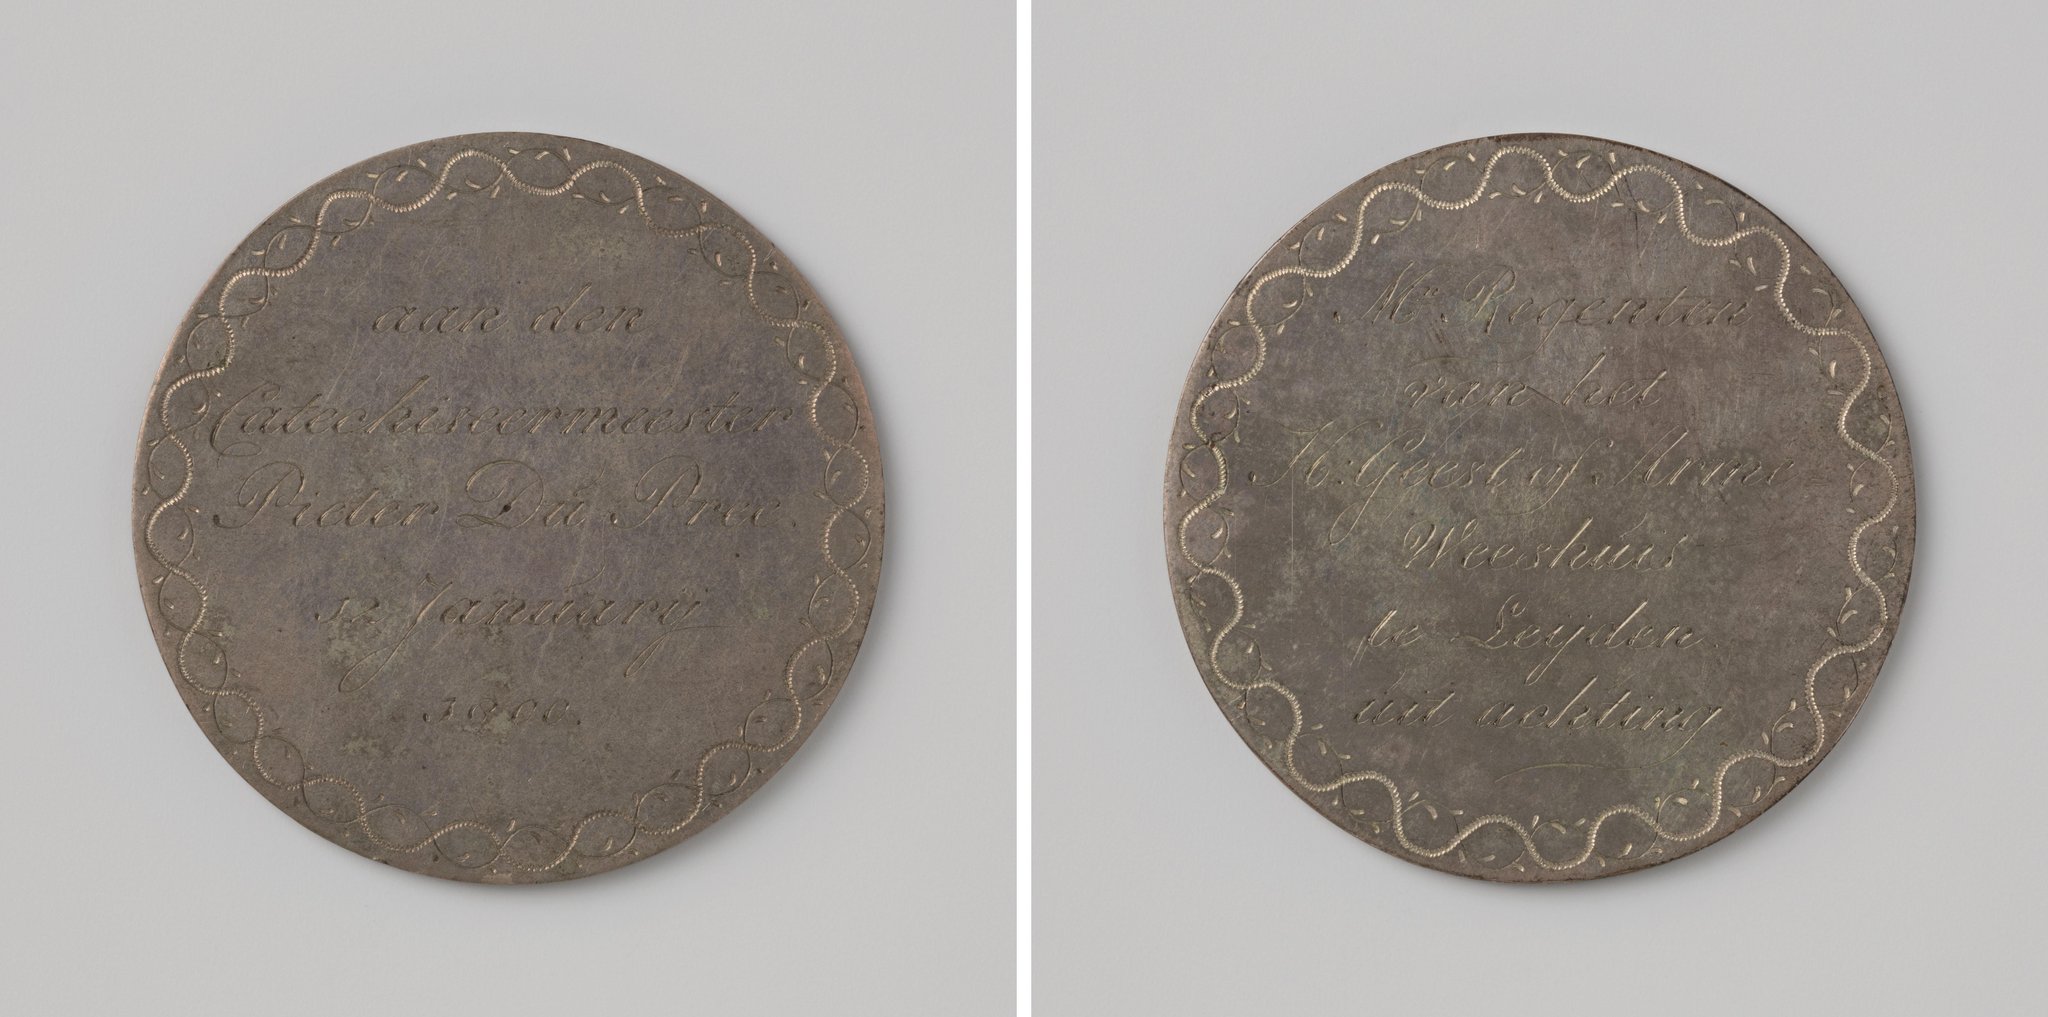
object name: honorary medal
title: Pieter Du Pree, meester catechisatie, penning door de regenten van het armenweeshuis te Leiden vereerd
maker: Anonymous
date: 1800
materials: silver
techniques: engraving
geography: leiden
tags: leiden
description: Zilveren penning. Voorzijde: opschrift binnen sierrand van bladertakken. Keerzijde: opschrift binnen sierrand van bladertakken